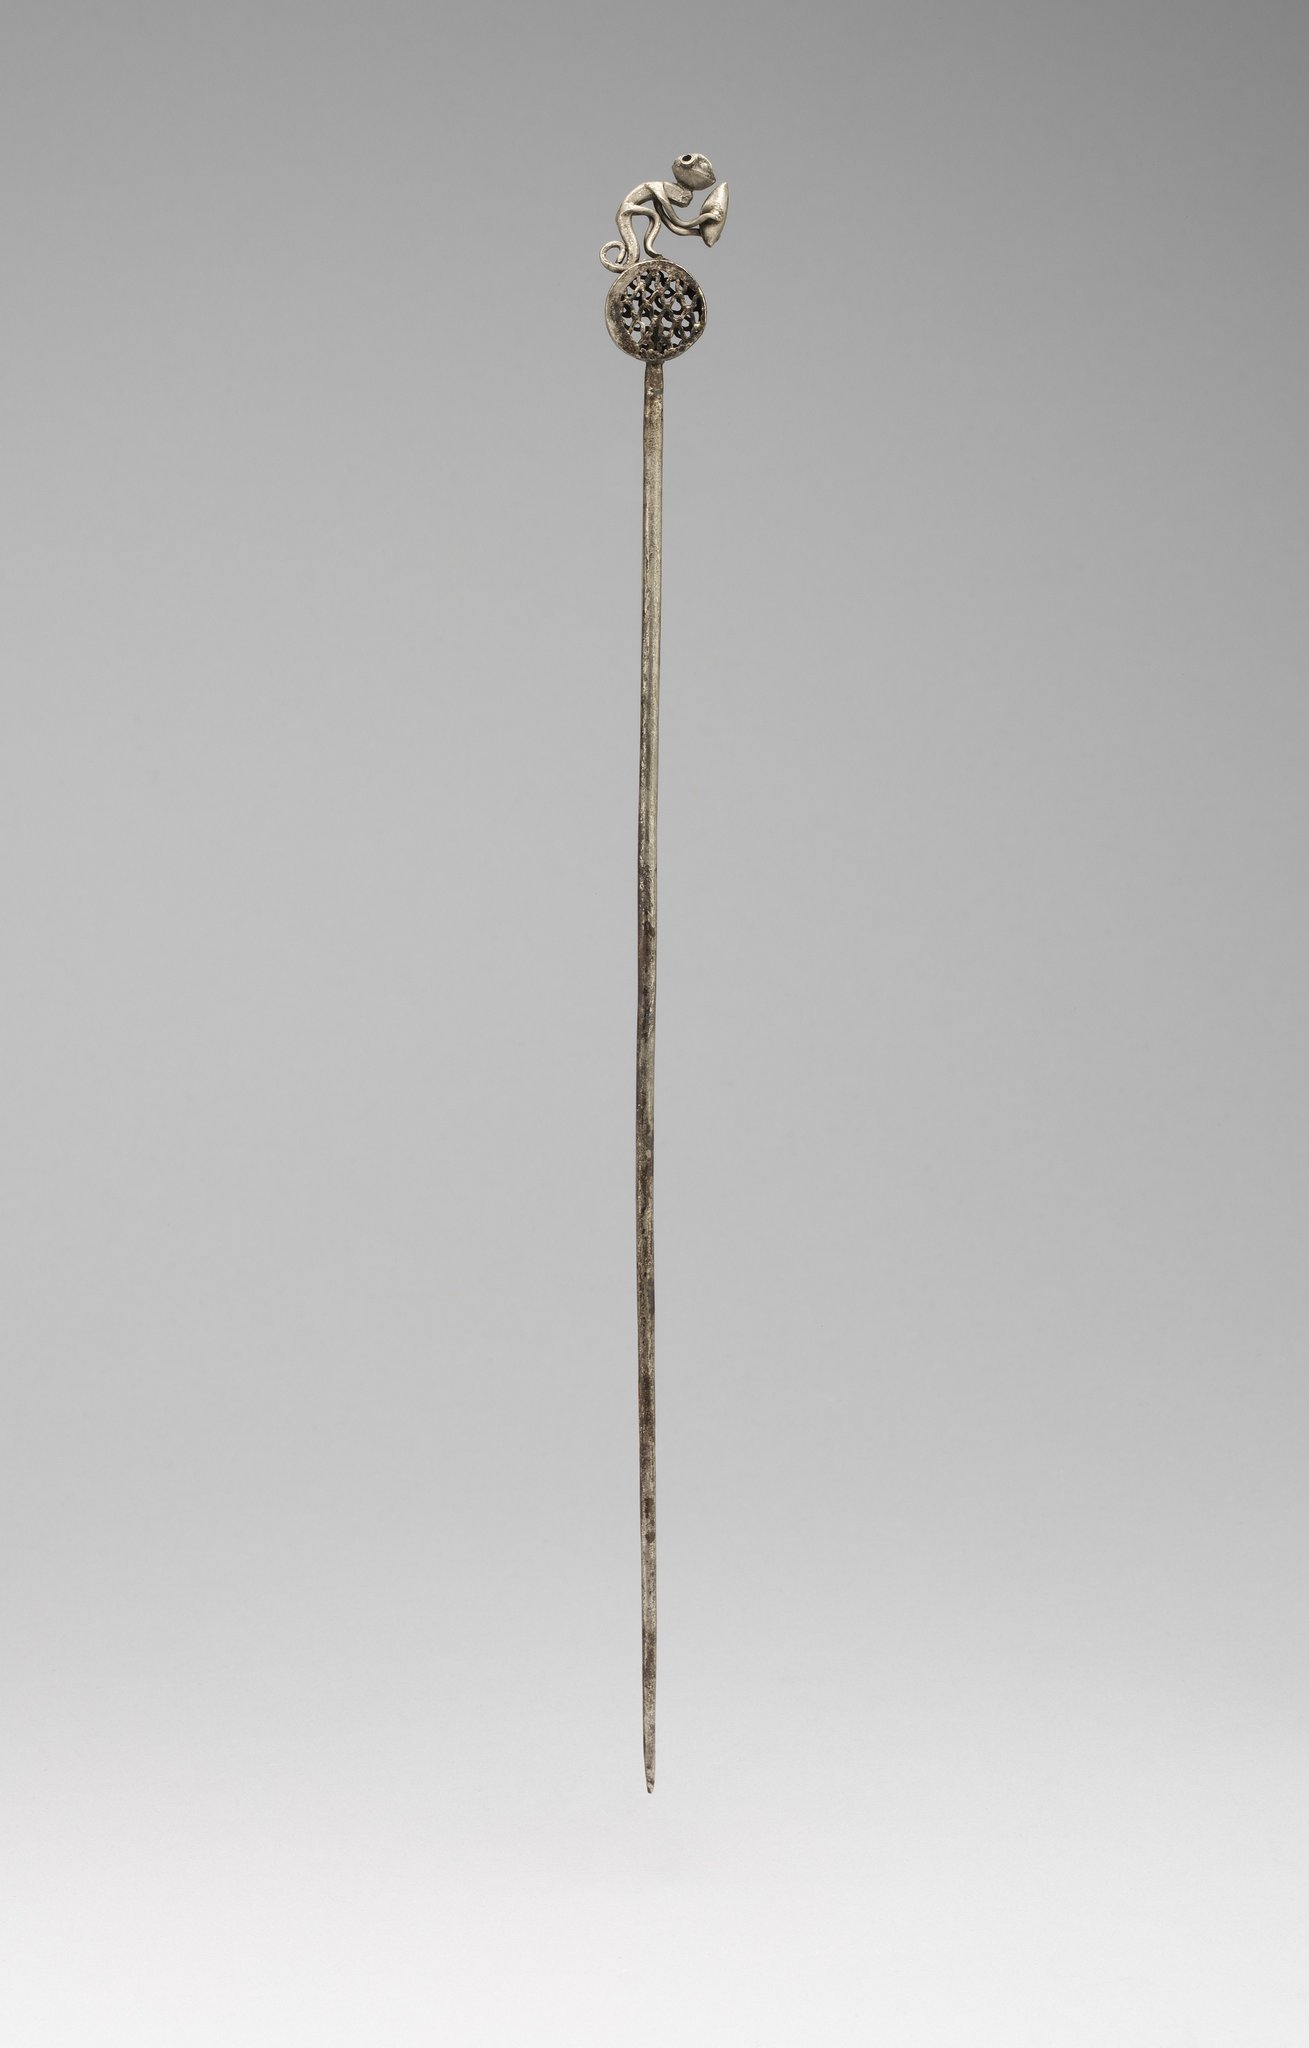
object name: pin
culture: chimú or inca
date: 1301-1500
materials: silver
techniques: hammering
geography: peru